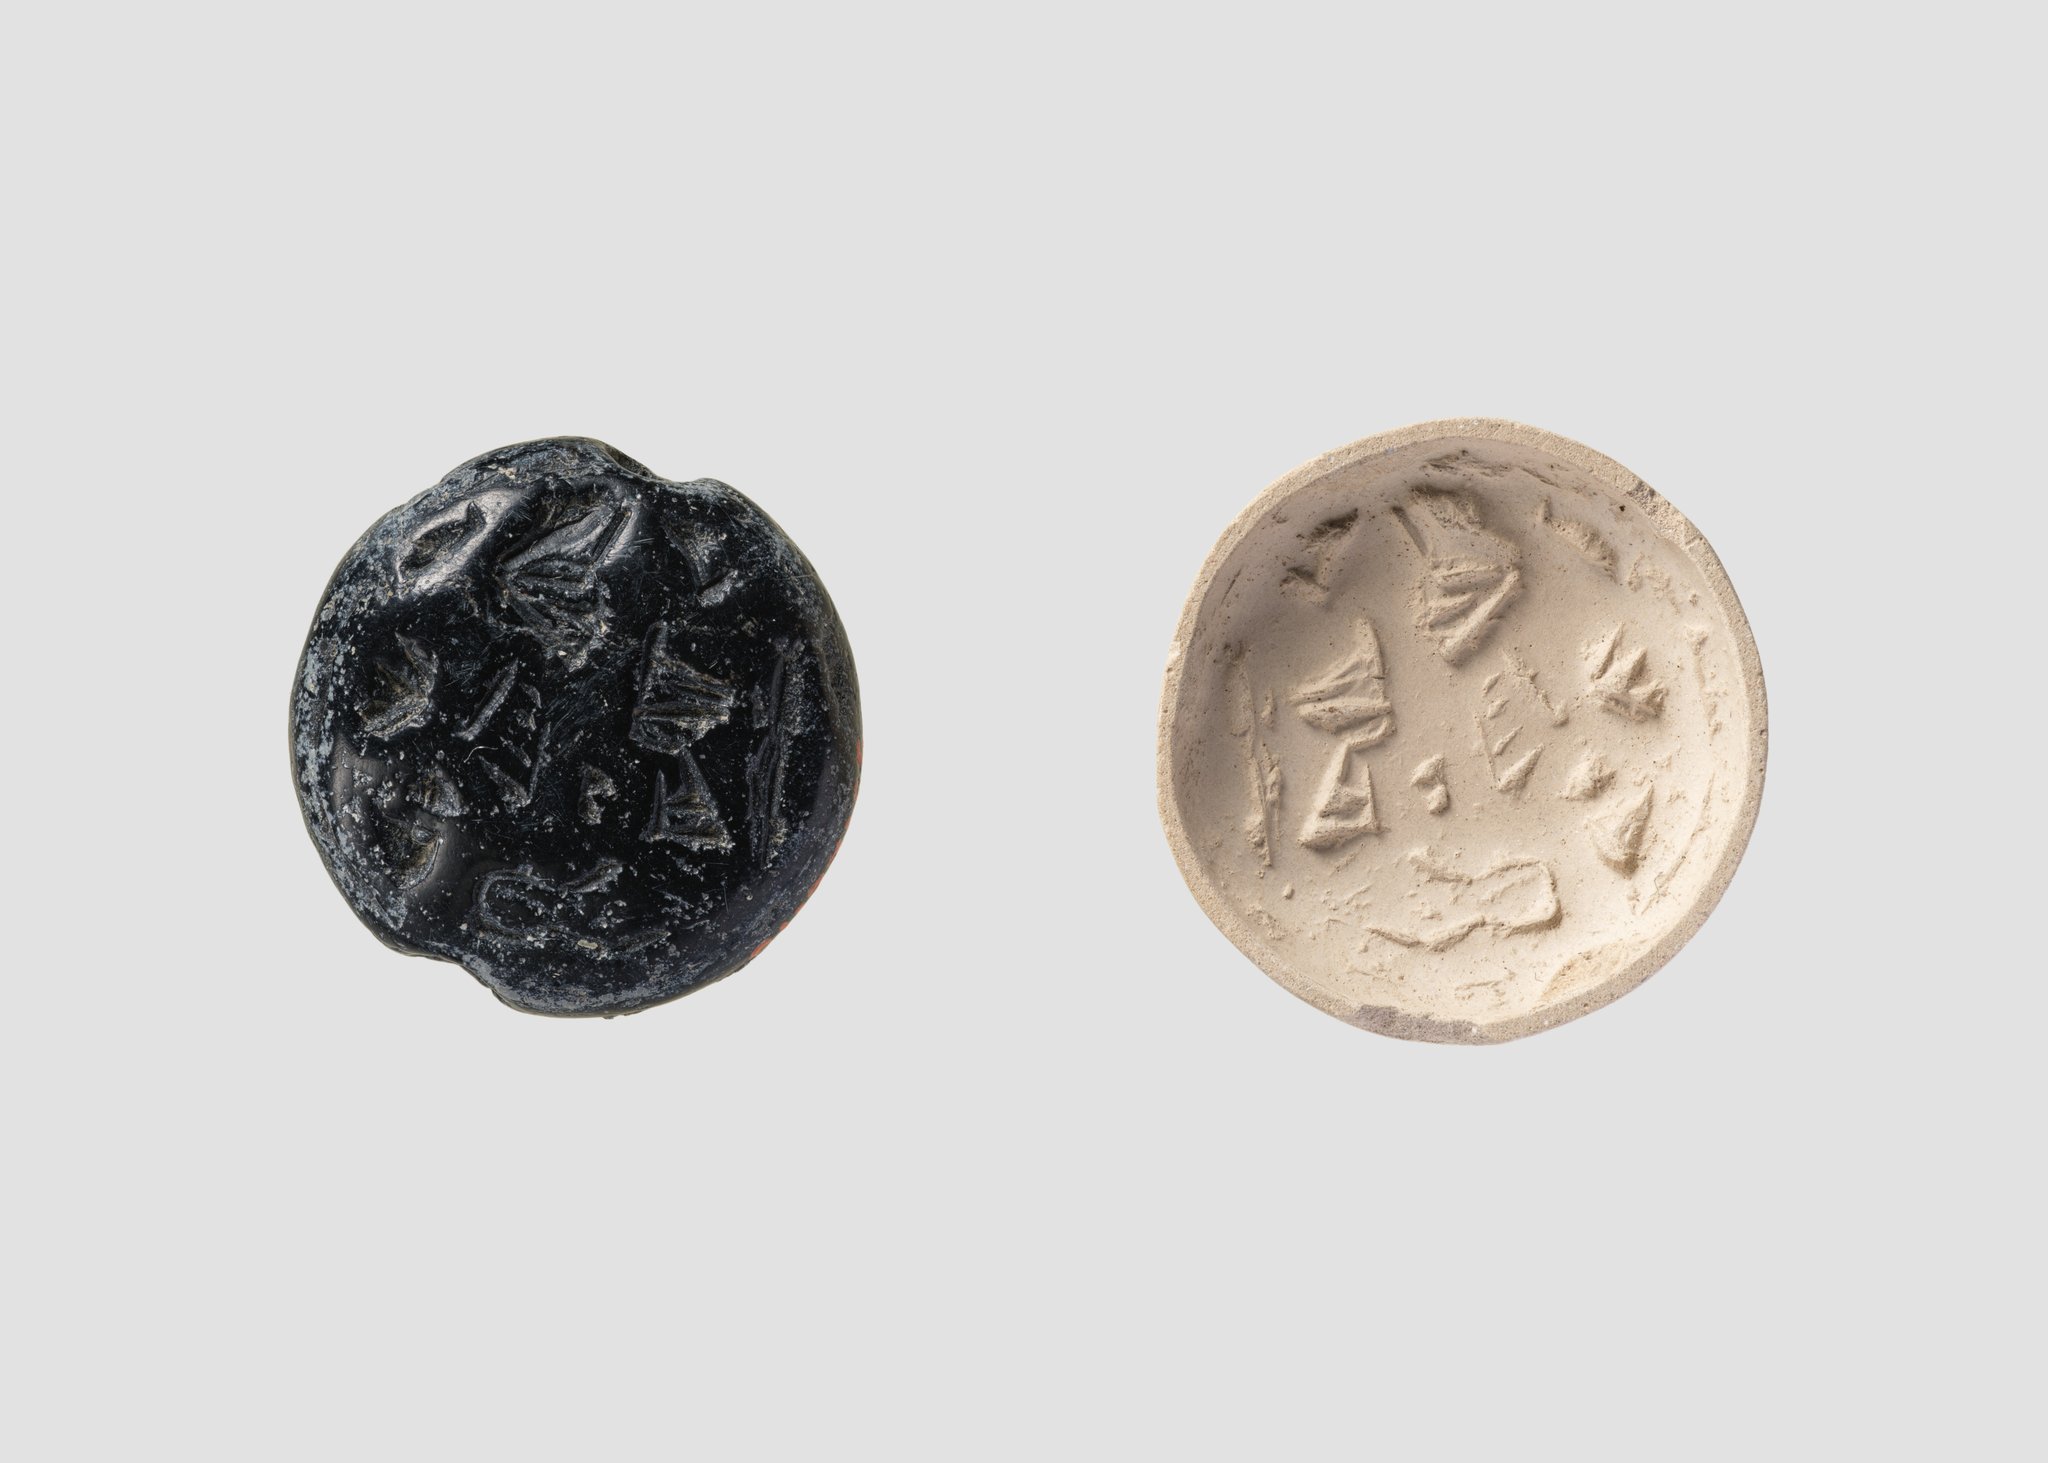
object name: stamp seal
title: Double convex discoid (bulla) seal engraved on two faces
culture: hittite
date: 1400-1200 BCE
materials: stone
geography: syria or anatolia